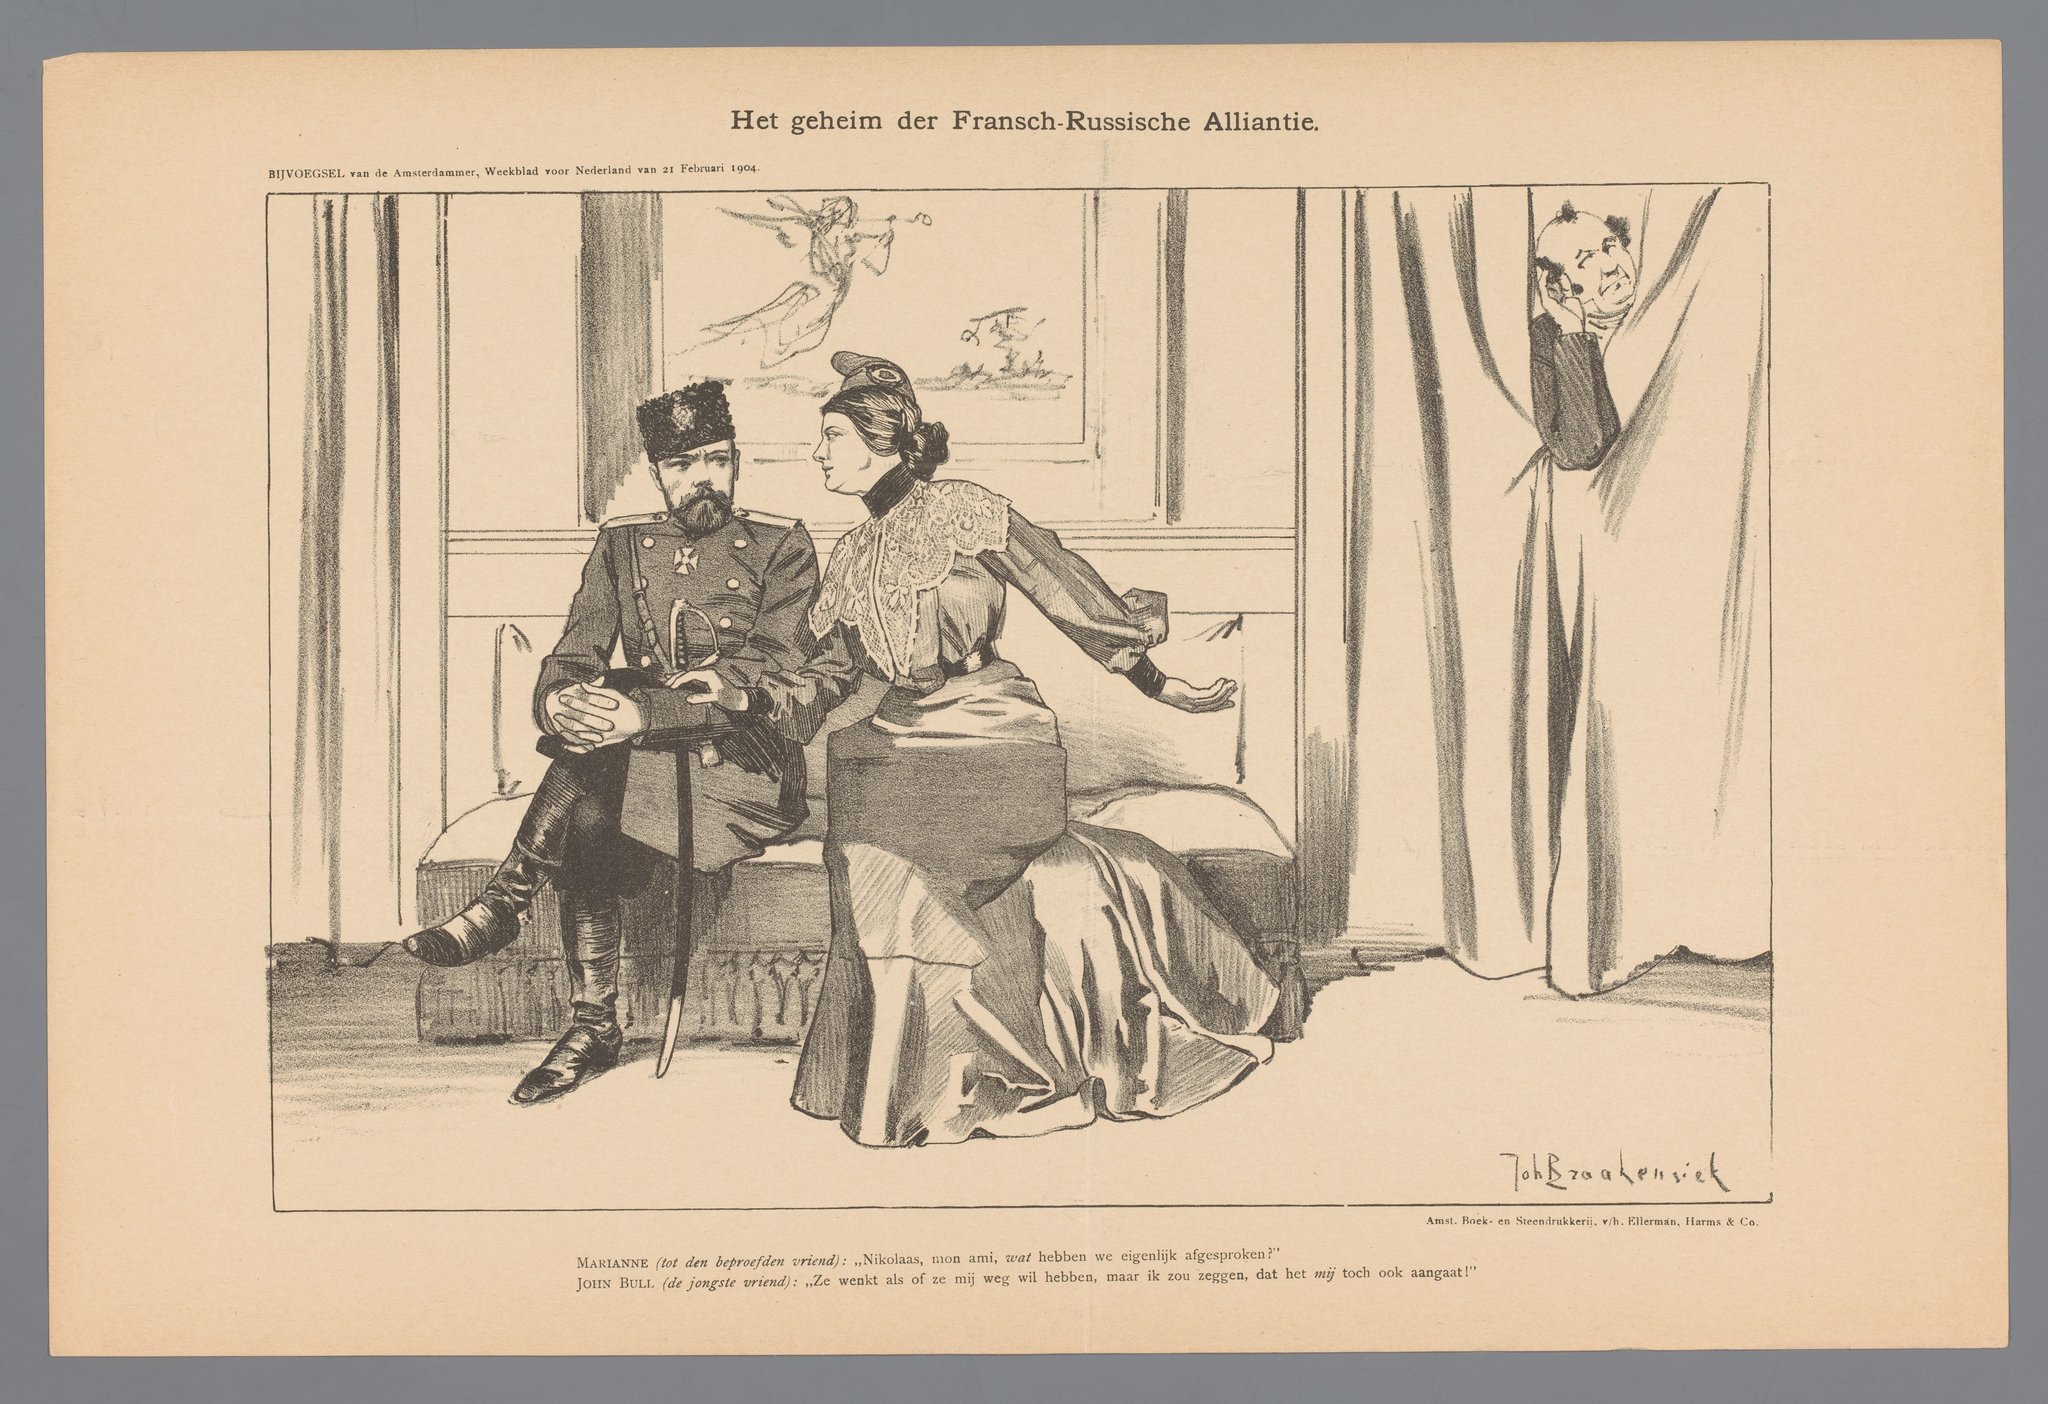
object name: cartoon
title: Het geheim der Fransch-Russische Alliantie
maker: johan braakensiek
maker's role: draughtsman, print maker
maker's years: 1858-1940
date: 1904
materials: paper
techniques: lithograph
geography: amsterdam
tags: historical persons, emperor, personifications of countries, nations, states, districts, etc. (+ nation; national), political caricatures and satires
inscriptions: date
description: Prent uit het bijvoegsel van: De Amsterdammer. Weekblad voor Nederland, 21 februari 1904.